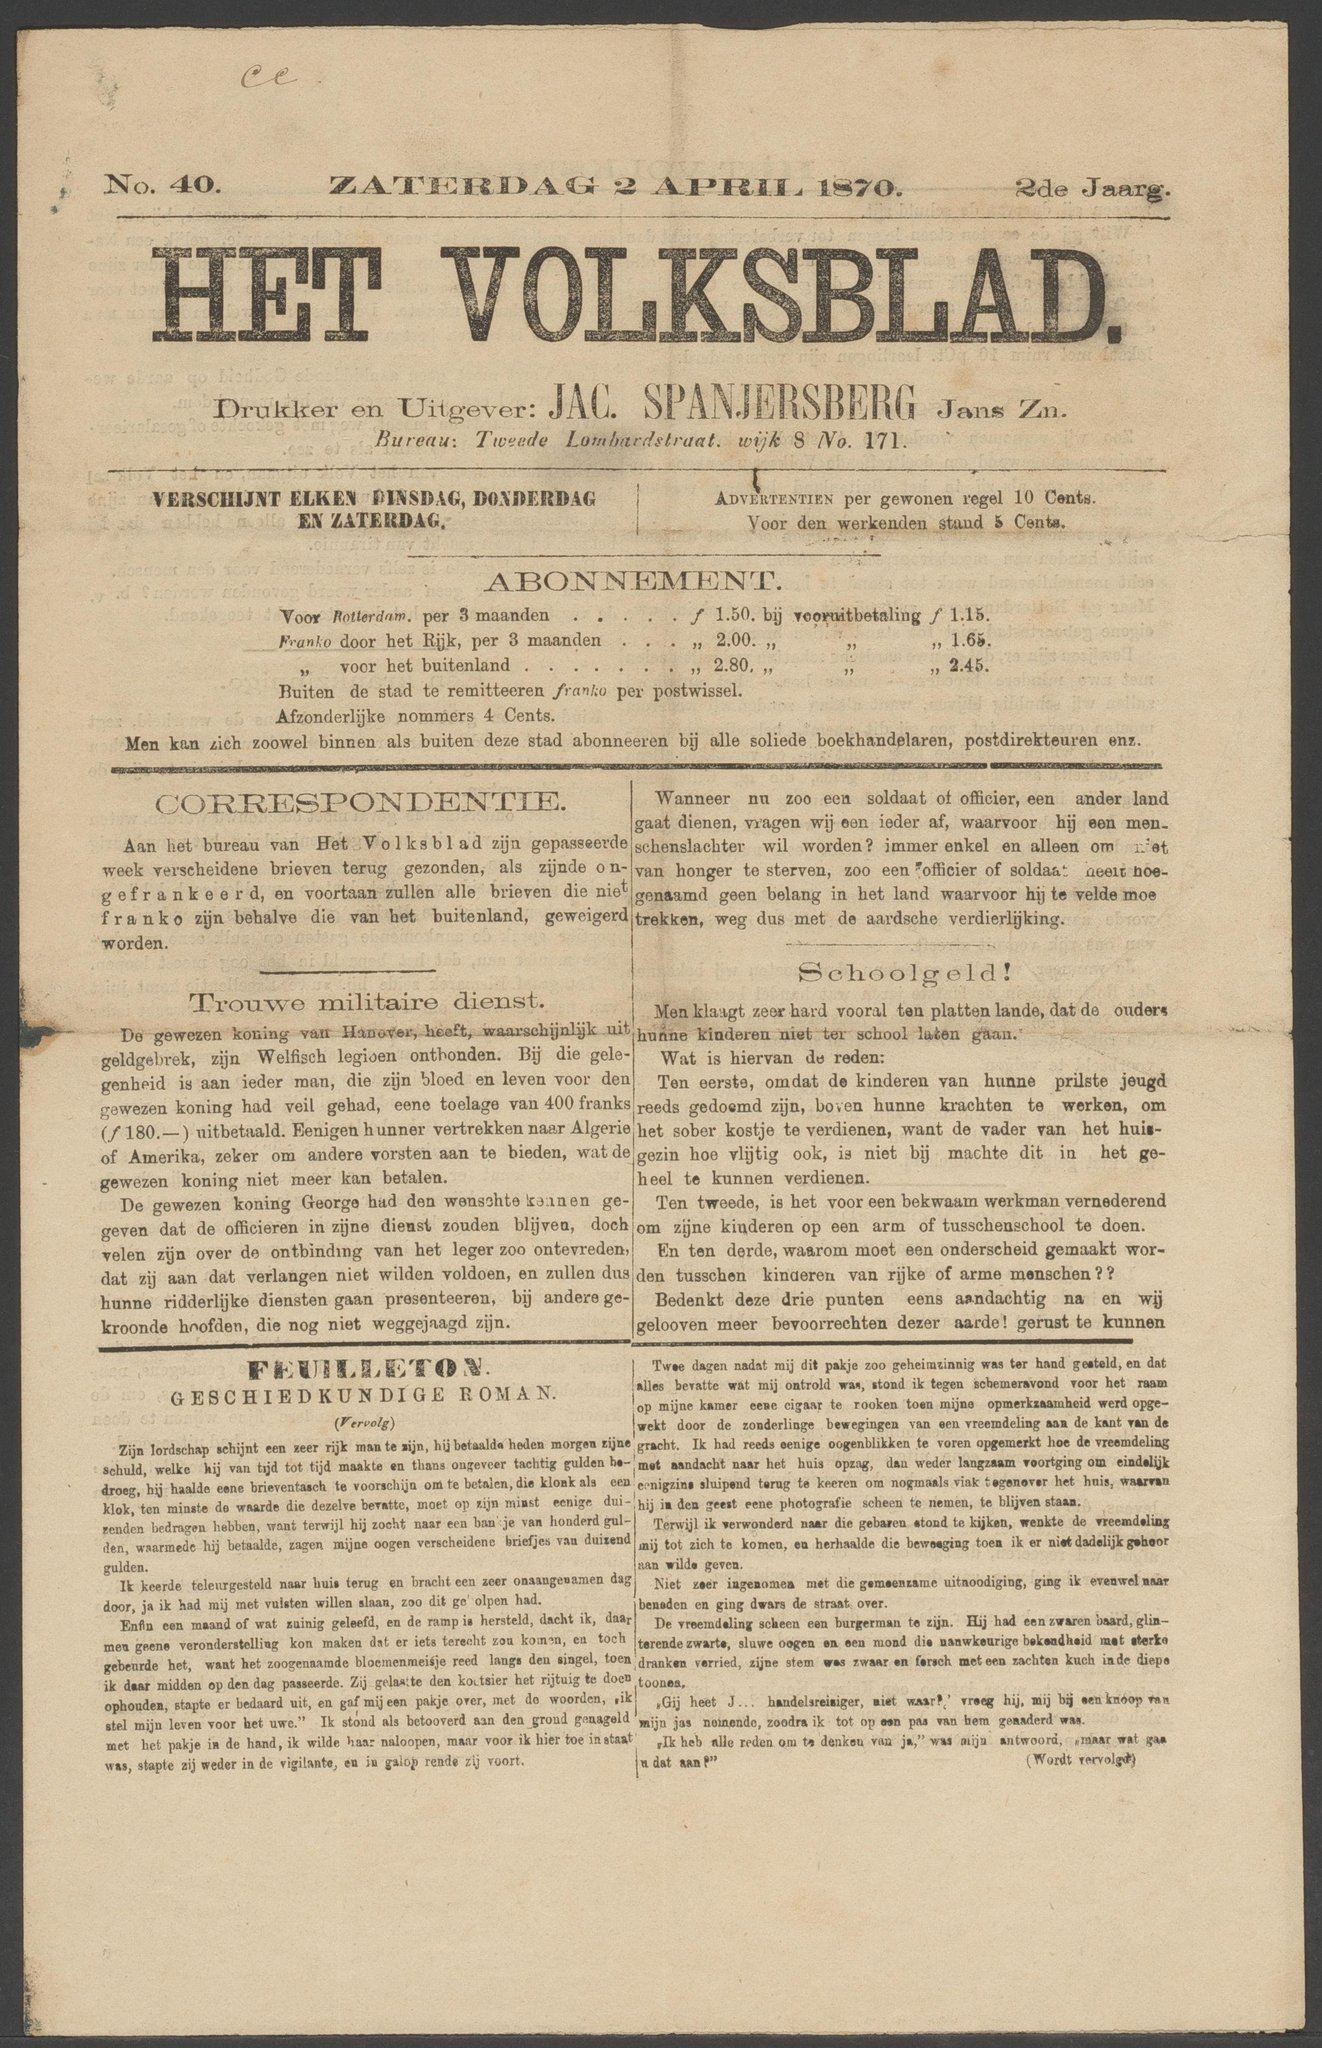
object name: newspaper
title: Het Volksblad, 2 april 1870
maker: jac. spanjersberg jans zn.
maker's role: printer, publisher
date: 1870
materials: paper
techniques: letterpress printing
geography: rotterdam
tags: newspaper, news-sheet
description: Exemplaar van de krant 'Het Volksblad' van 2 april 1870. Dubbelbladig, alle zijden bedrukt. Bovenaan een vignet met Mercurius. Rechtsboven twee stempels van betaalde accijnzen. Onderwerpsrubrieken binnen de Atlas Zeden en Gewoonten: Regeering, Officieele Nieuwsbladen.